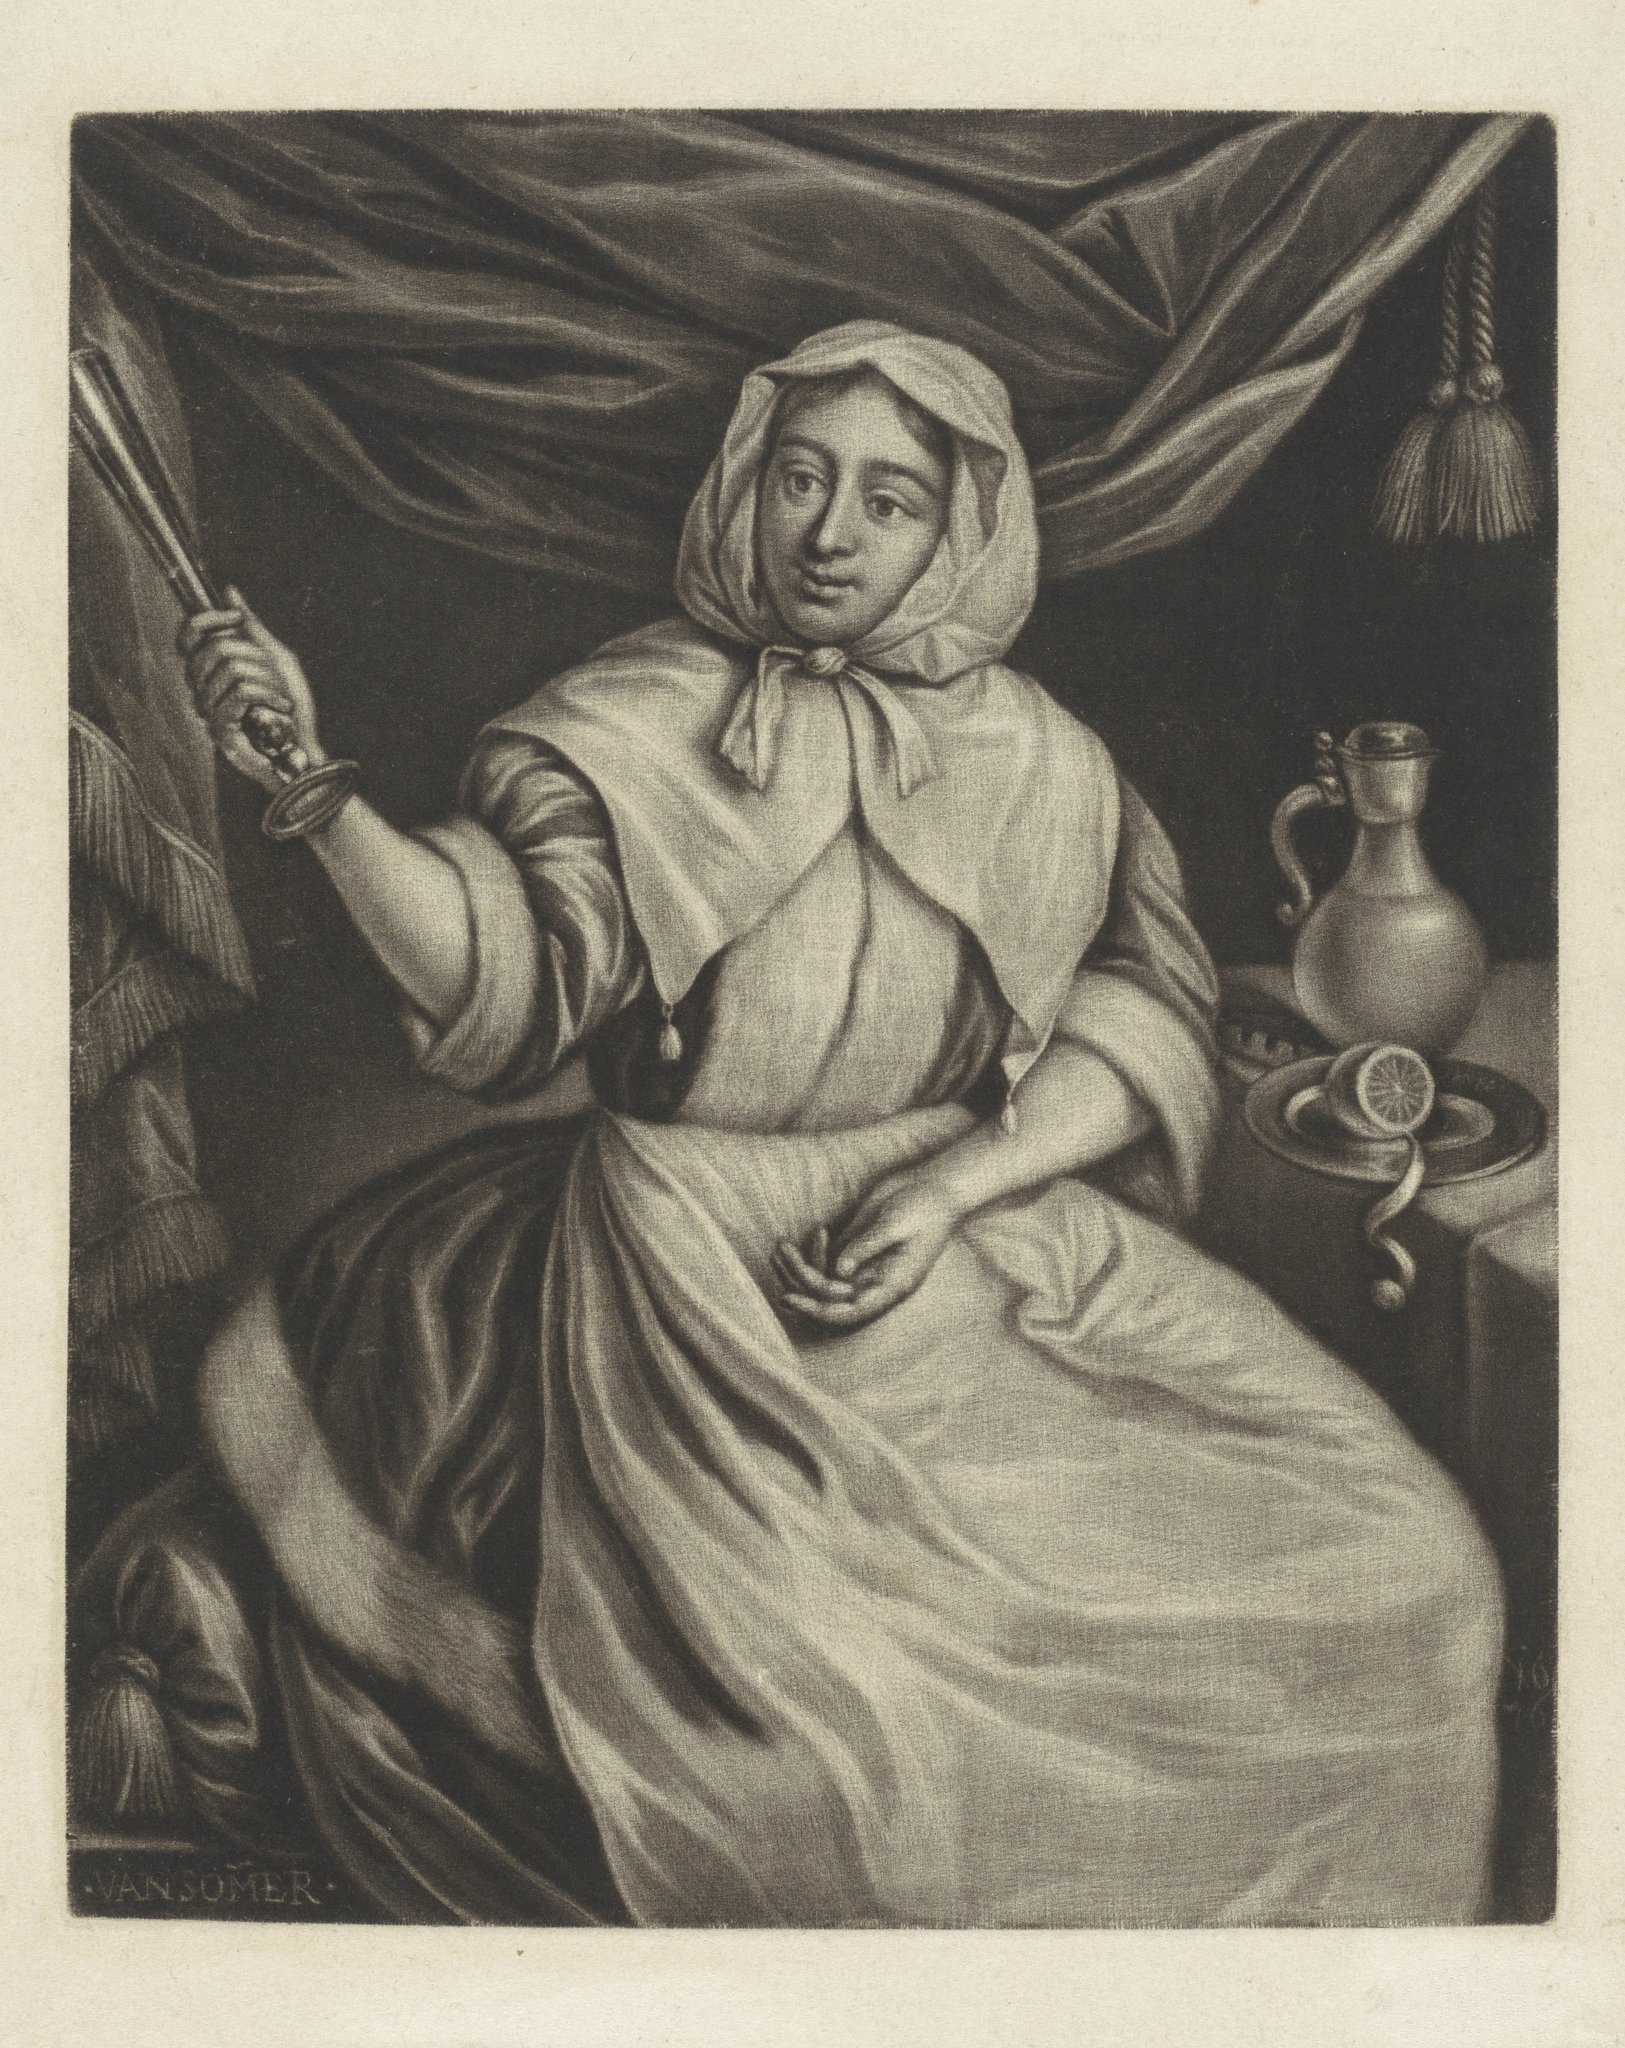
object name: print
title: Vrouw met een glas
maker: jan van somer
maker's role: draughtsman, print maker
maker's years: 1645-1699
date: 1676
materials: paper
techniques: mezzotint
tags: sluggishness, inertia; 'dapocaggine', 'pigritia' (ripa), glass, rummer, drinking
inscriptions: collector's mark: Lugt 2228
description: Een vrouw heft een glas. Op de tafel naast haar een bord met een geschilde citroen en een kan. Mogelijk verbeeldt ze luiheid.